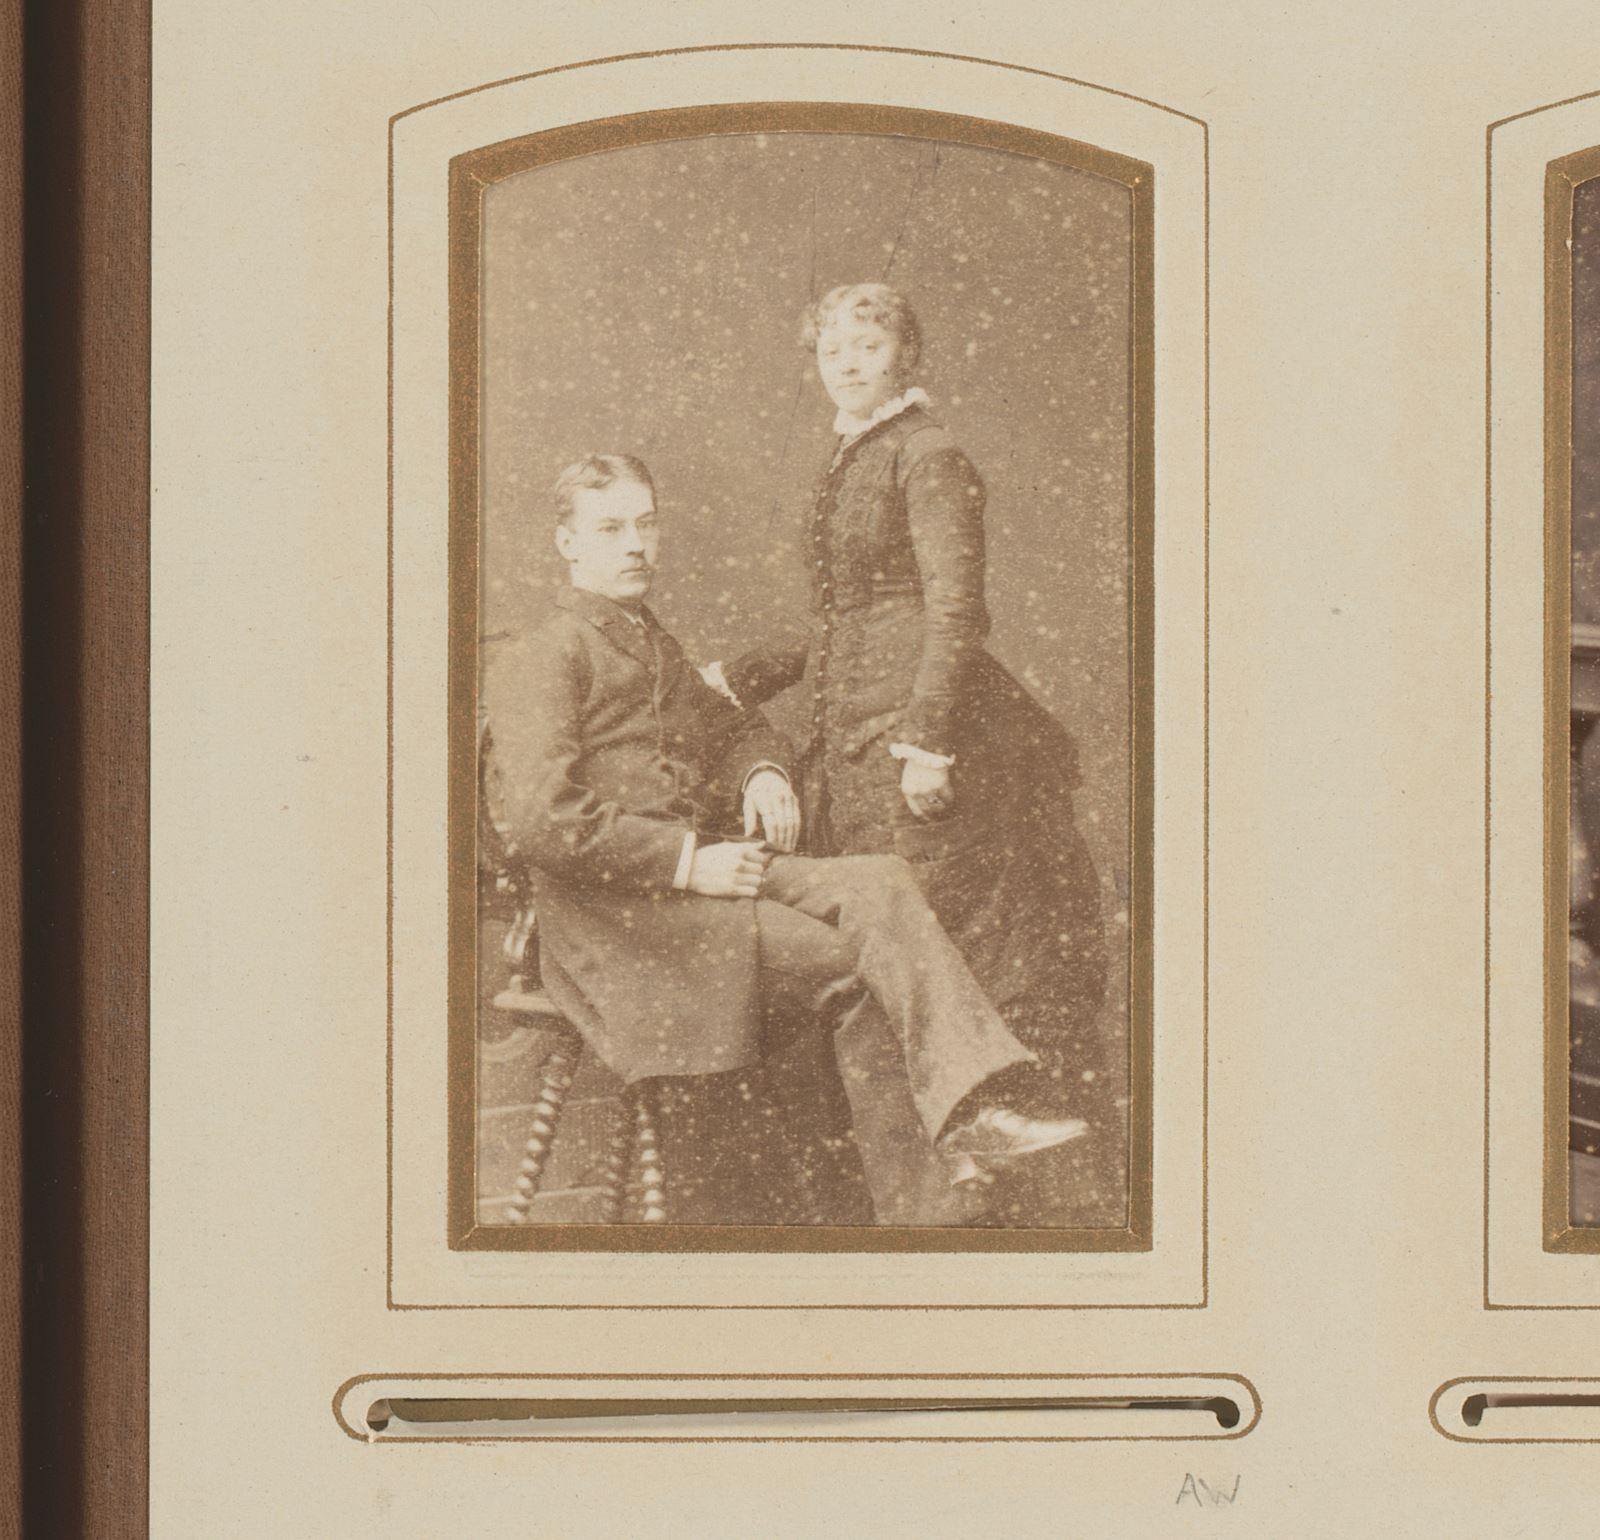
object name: photograph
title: Portret van een zittende man en een staande vrouw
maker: ed. radermacher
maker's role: fotograaf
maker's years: 1839-1908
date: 1871-1893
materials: cardboard, photographic support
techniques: albumen print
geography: rotterdam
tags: sitting figure, historical persons - bb - woman, historical persons, standing figure - aa - female human figure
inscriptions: inscription: ‘Ed. Radermacher/ PHOTOGRAPHE/ Rotterdam/ KRUISKADE/ Hoek Kerklaan.’